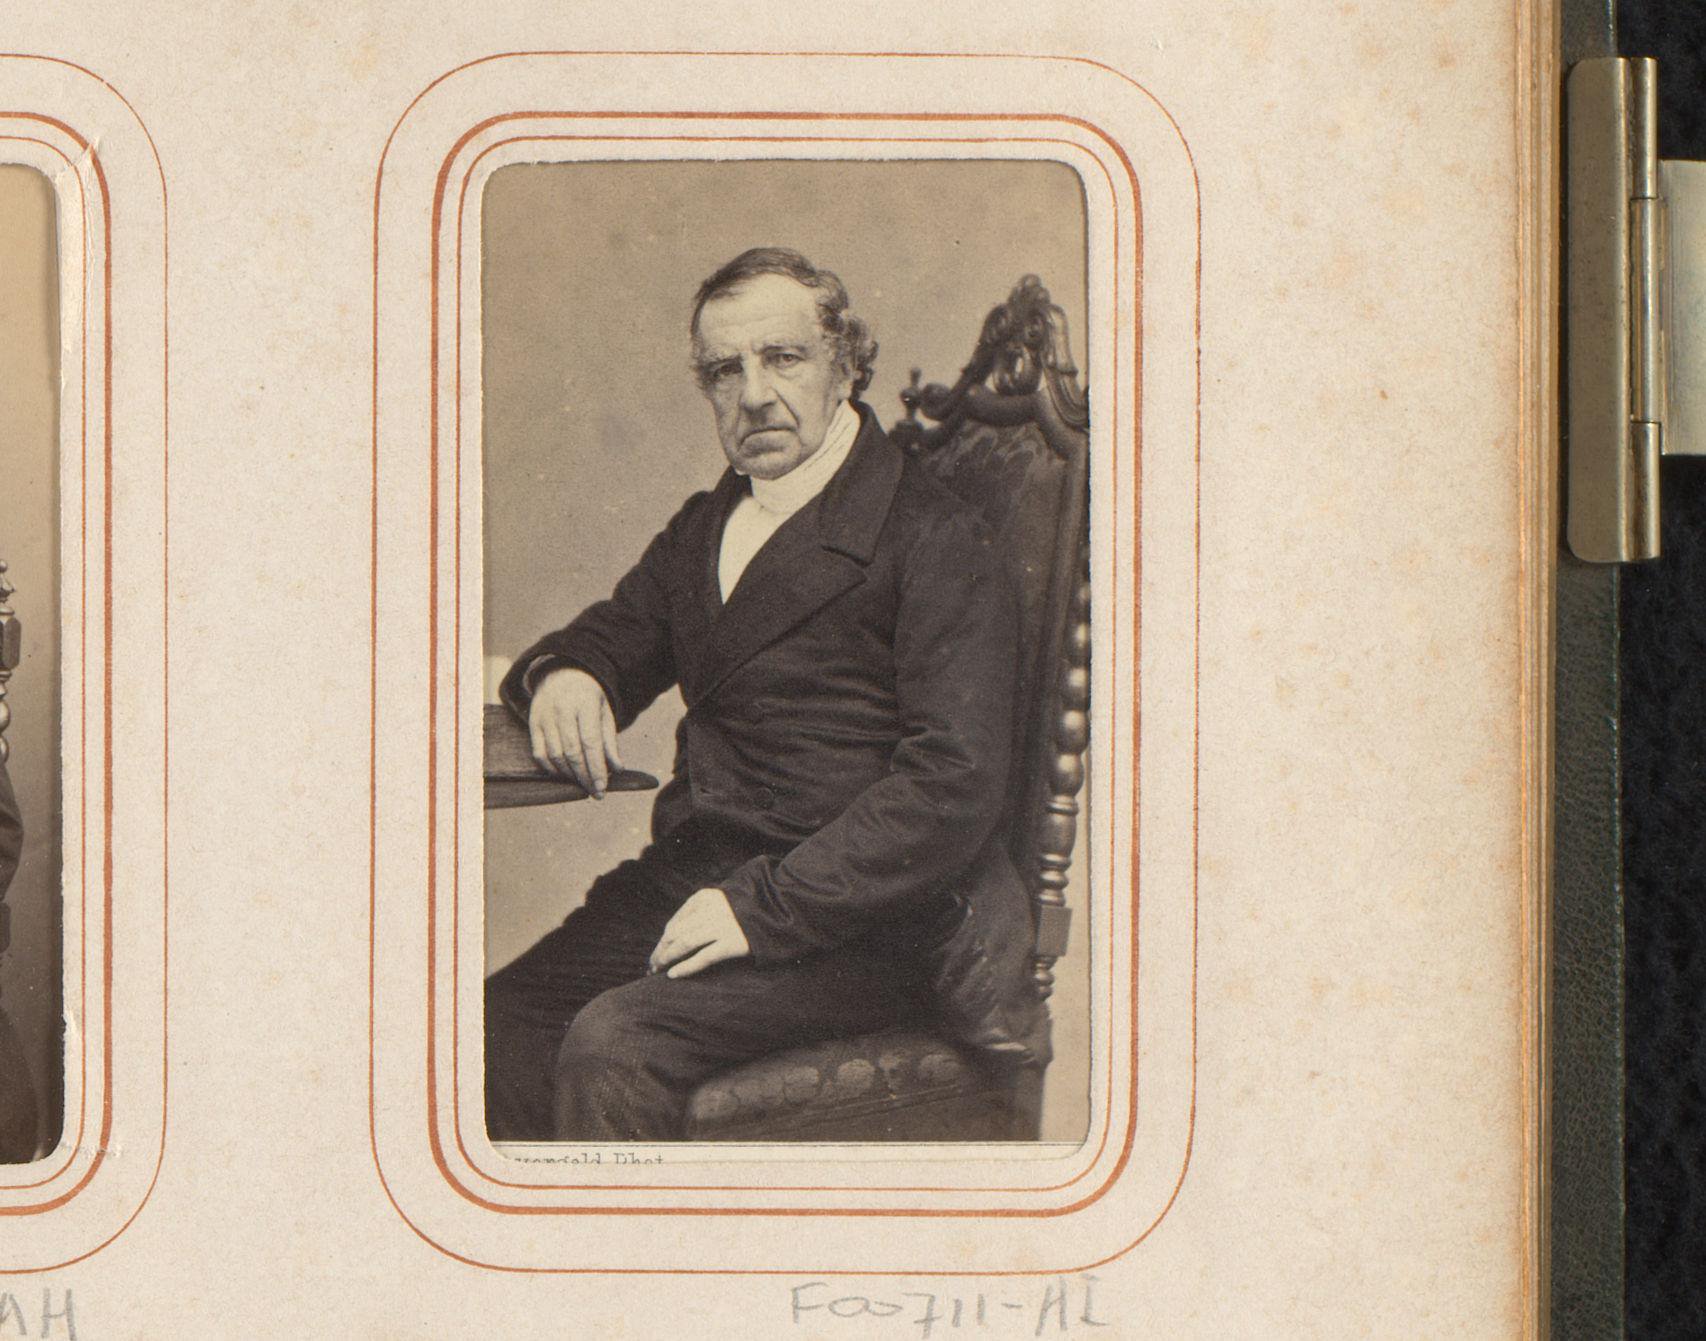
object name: photograph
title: Portret van een zittende oude man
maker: jan rudolf frederik nievergeld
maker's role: docent, fotograaf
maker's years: 1826-1898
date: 1859-1868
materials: cardboard, photographic support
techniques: albumen print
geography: the hague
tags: historical persons, old man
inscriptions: inscription: ‘J.R.F. Nievergeld/ Photographe/ Z.O. Buitencingel 228/ 's Gravenhage’